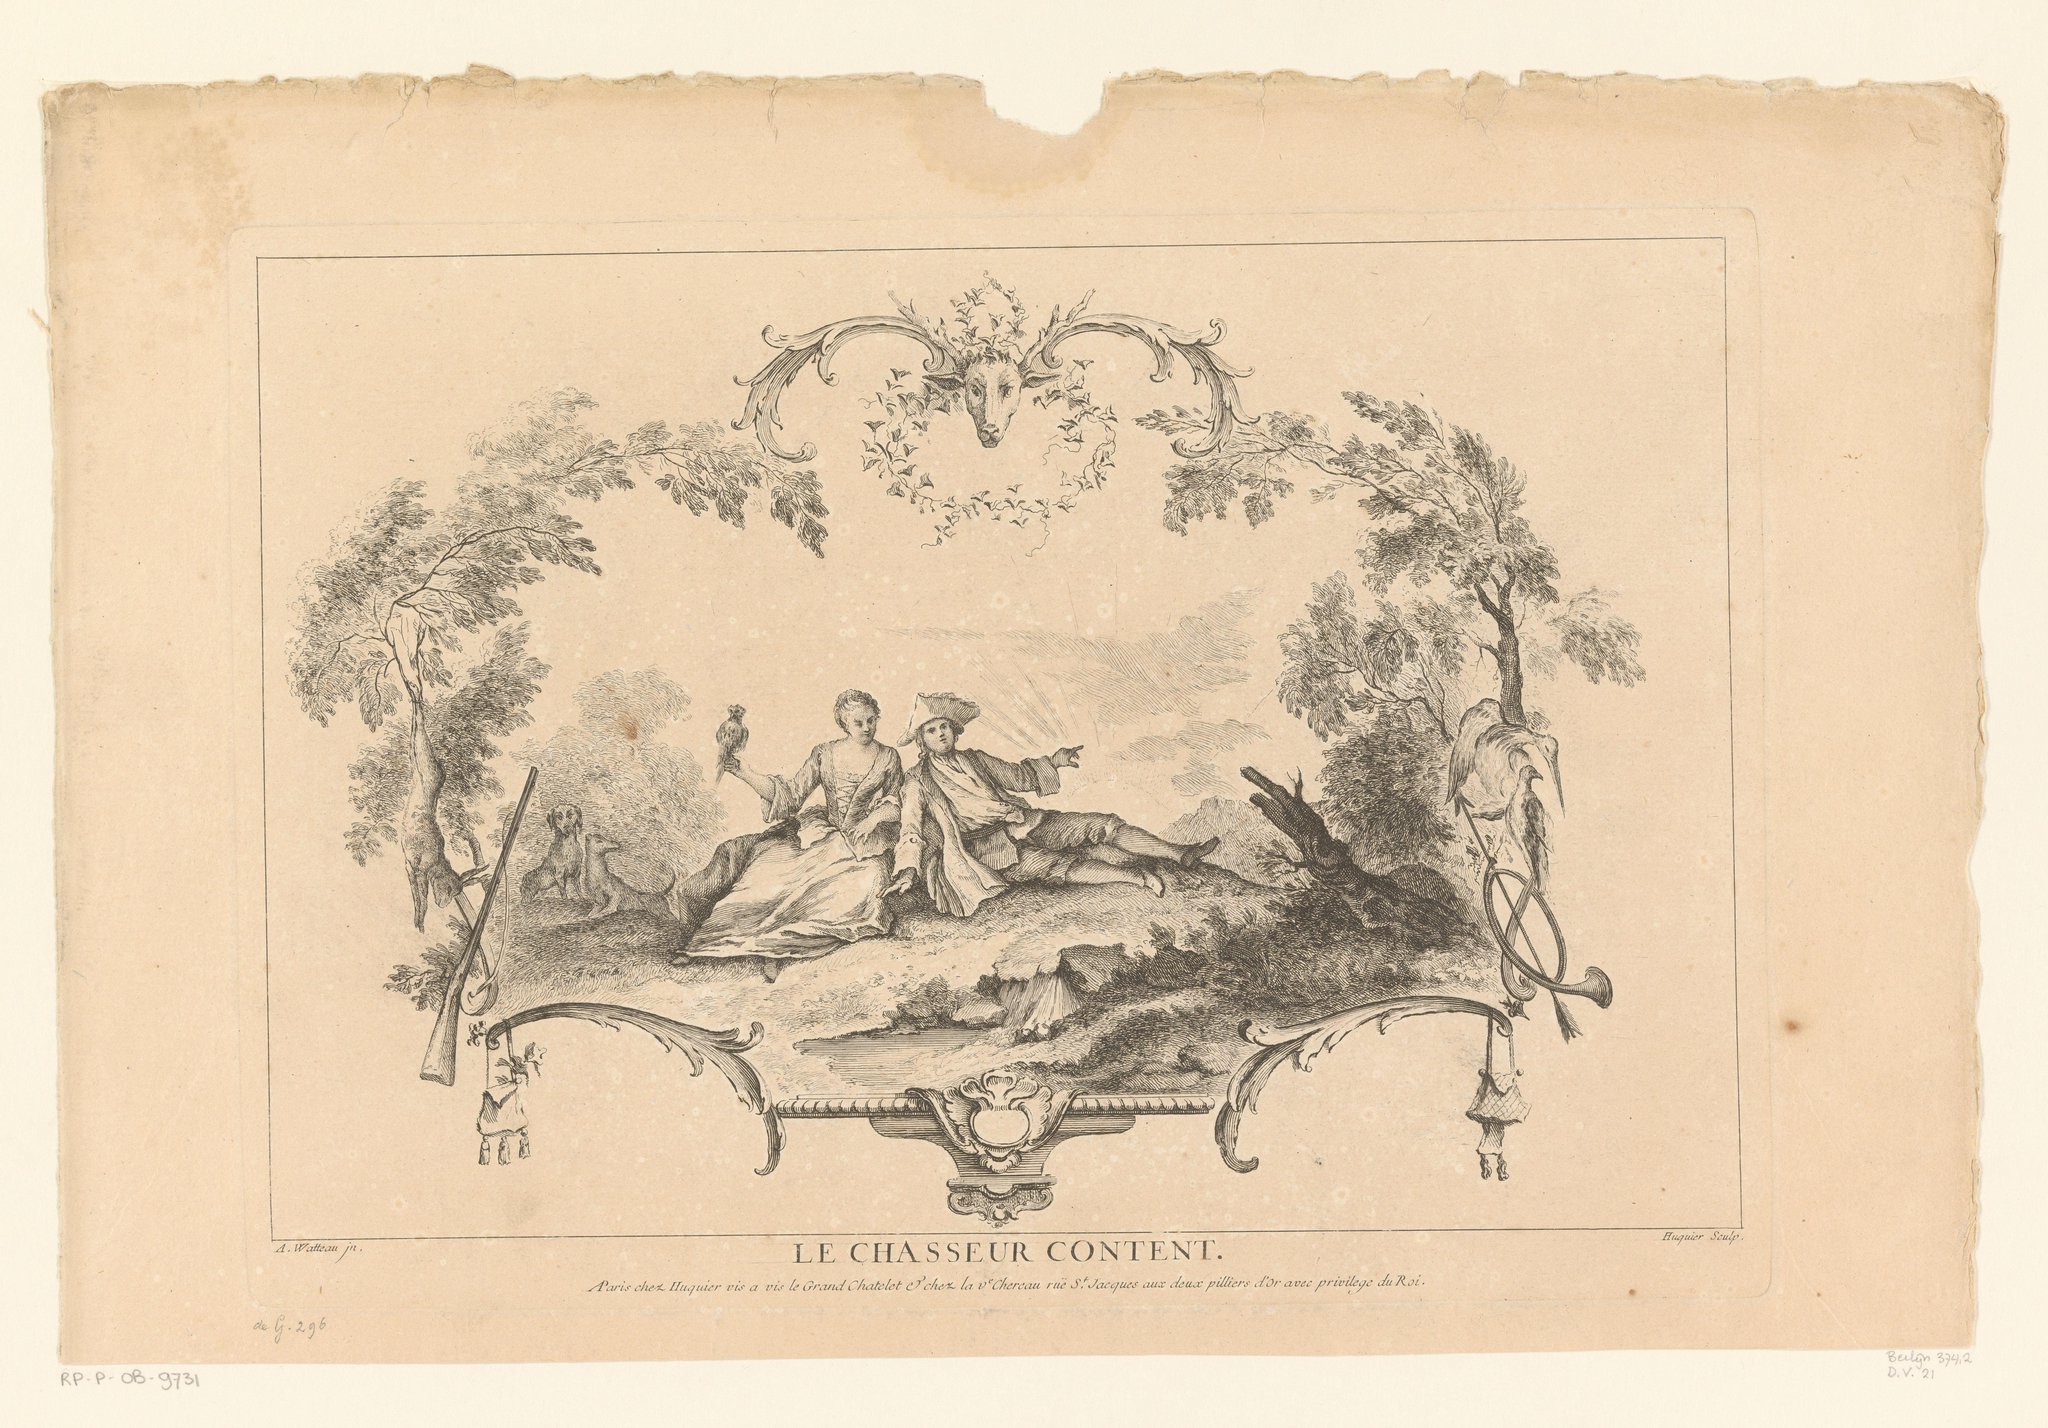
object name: print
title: Le Chasseur Content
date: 1729-1737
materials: paper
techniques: etching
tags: hunter, hunters resting during the hunt, landscapes (+ landscape with figures, staffage)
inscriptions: collector's mark: Lugt 2228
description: In een landschap zitten een jager en een vrouw met een vogel en twee honden. Rondom de voorstelling een ornamentele omlijsting met jachtattributen.